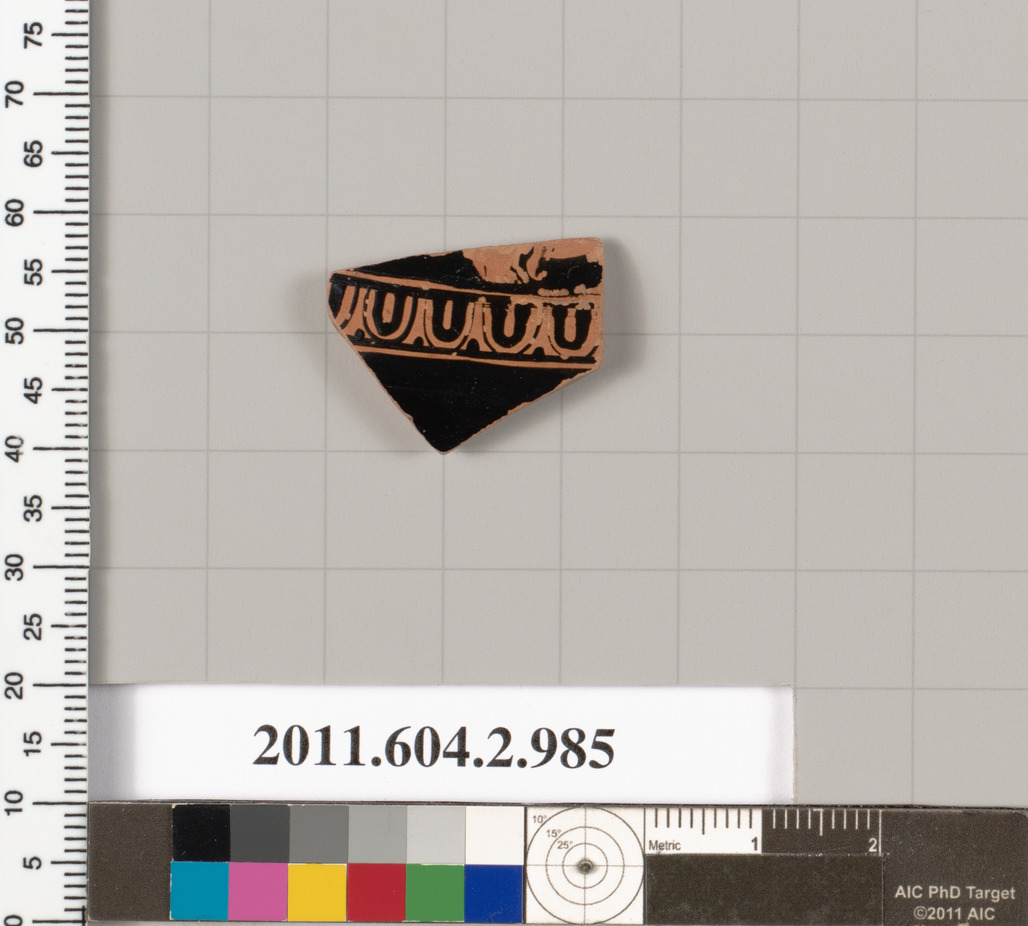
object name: chou fragment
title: Terracotta fragment of an oinochoe: chous (jug)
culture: greek, attic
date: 460-440 BCE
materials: terracotta